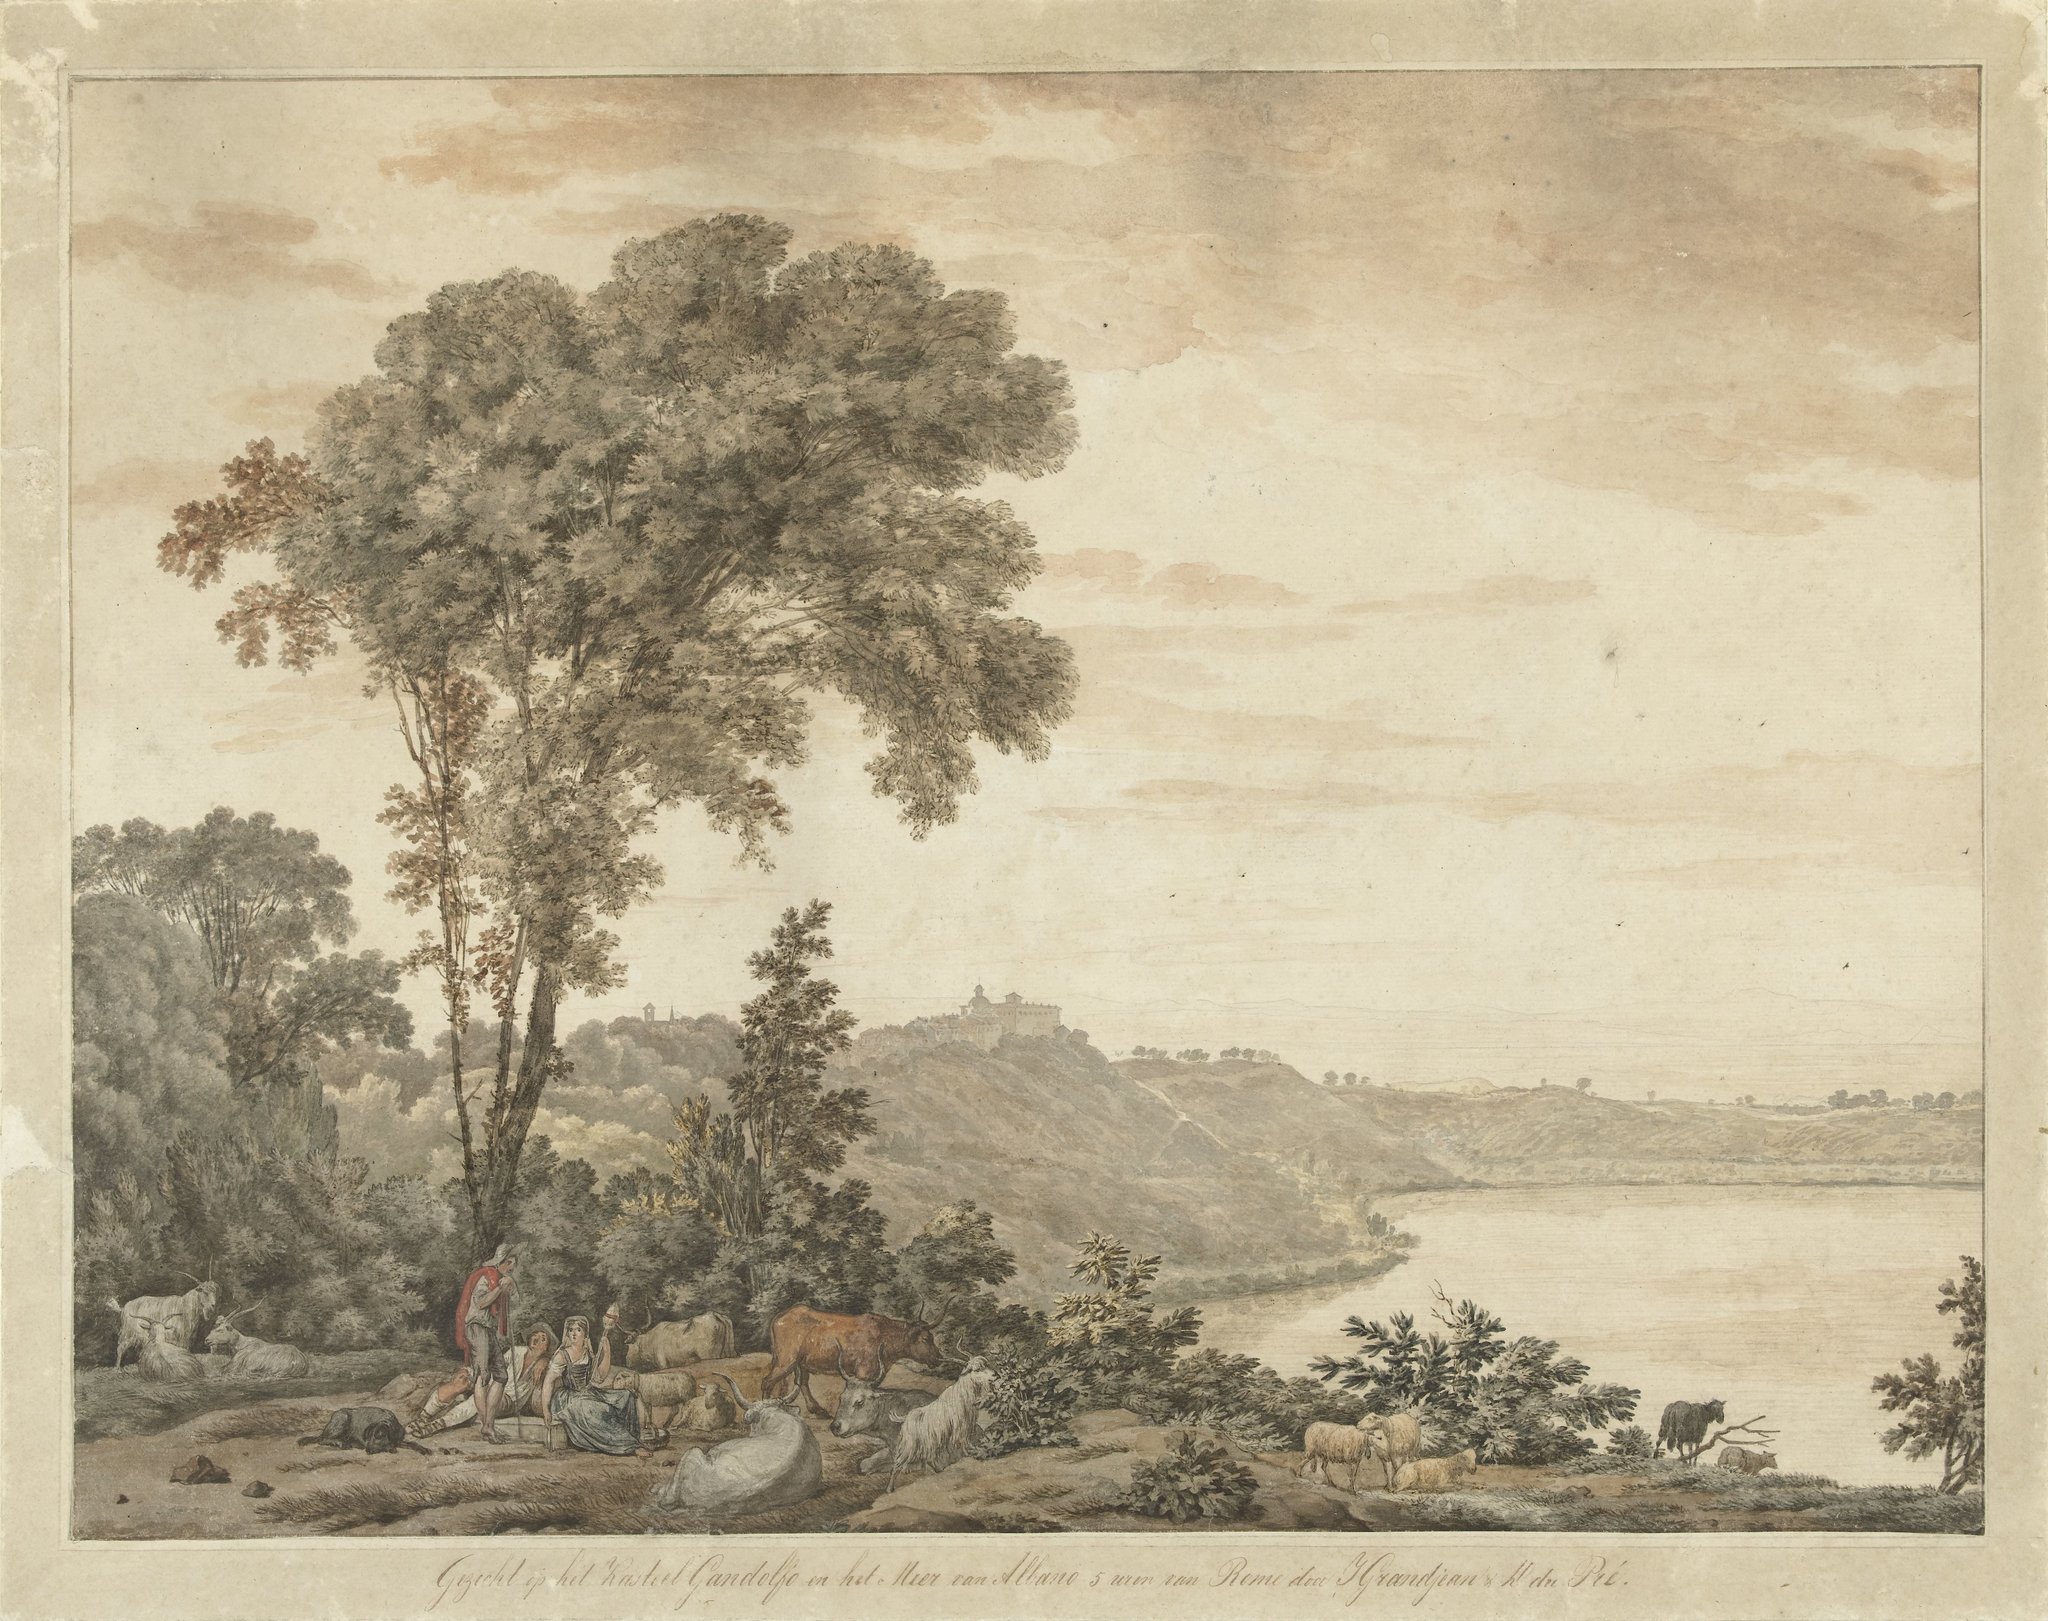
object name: watercolor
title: Gezicht op Castel Gandolfo en het meer van Albano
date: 1761-1817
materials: ink, paper, pencil, watercolor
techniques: brush, pen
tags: prospect of city, town panorama, silhouette of city